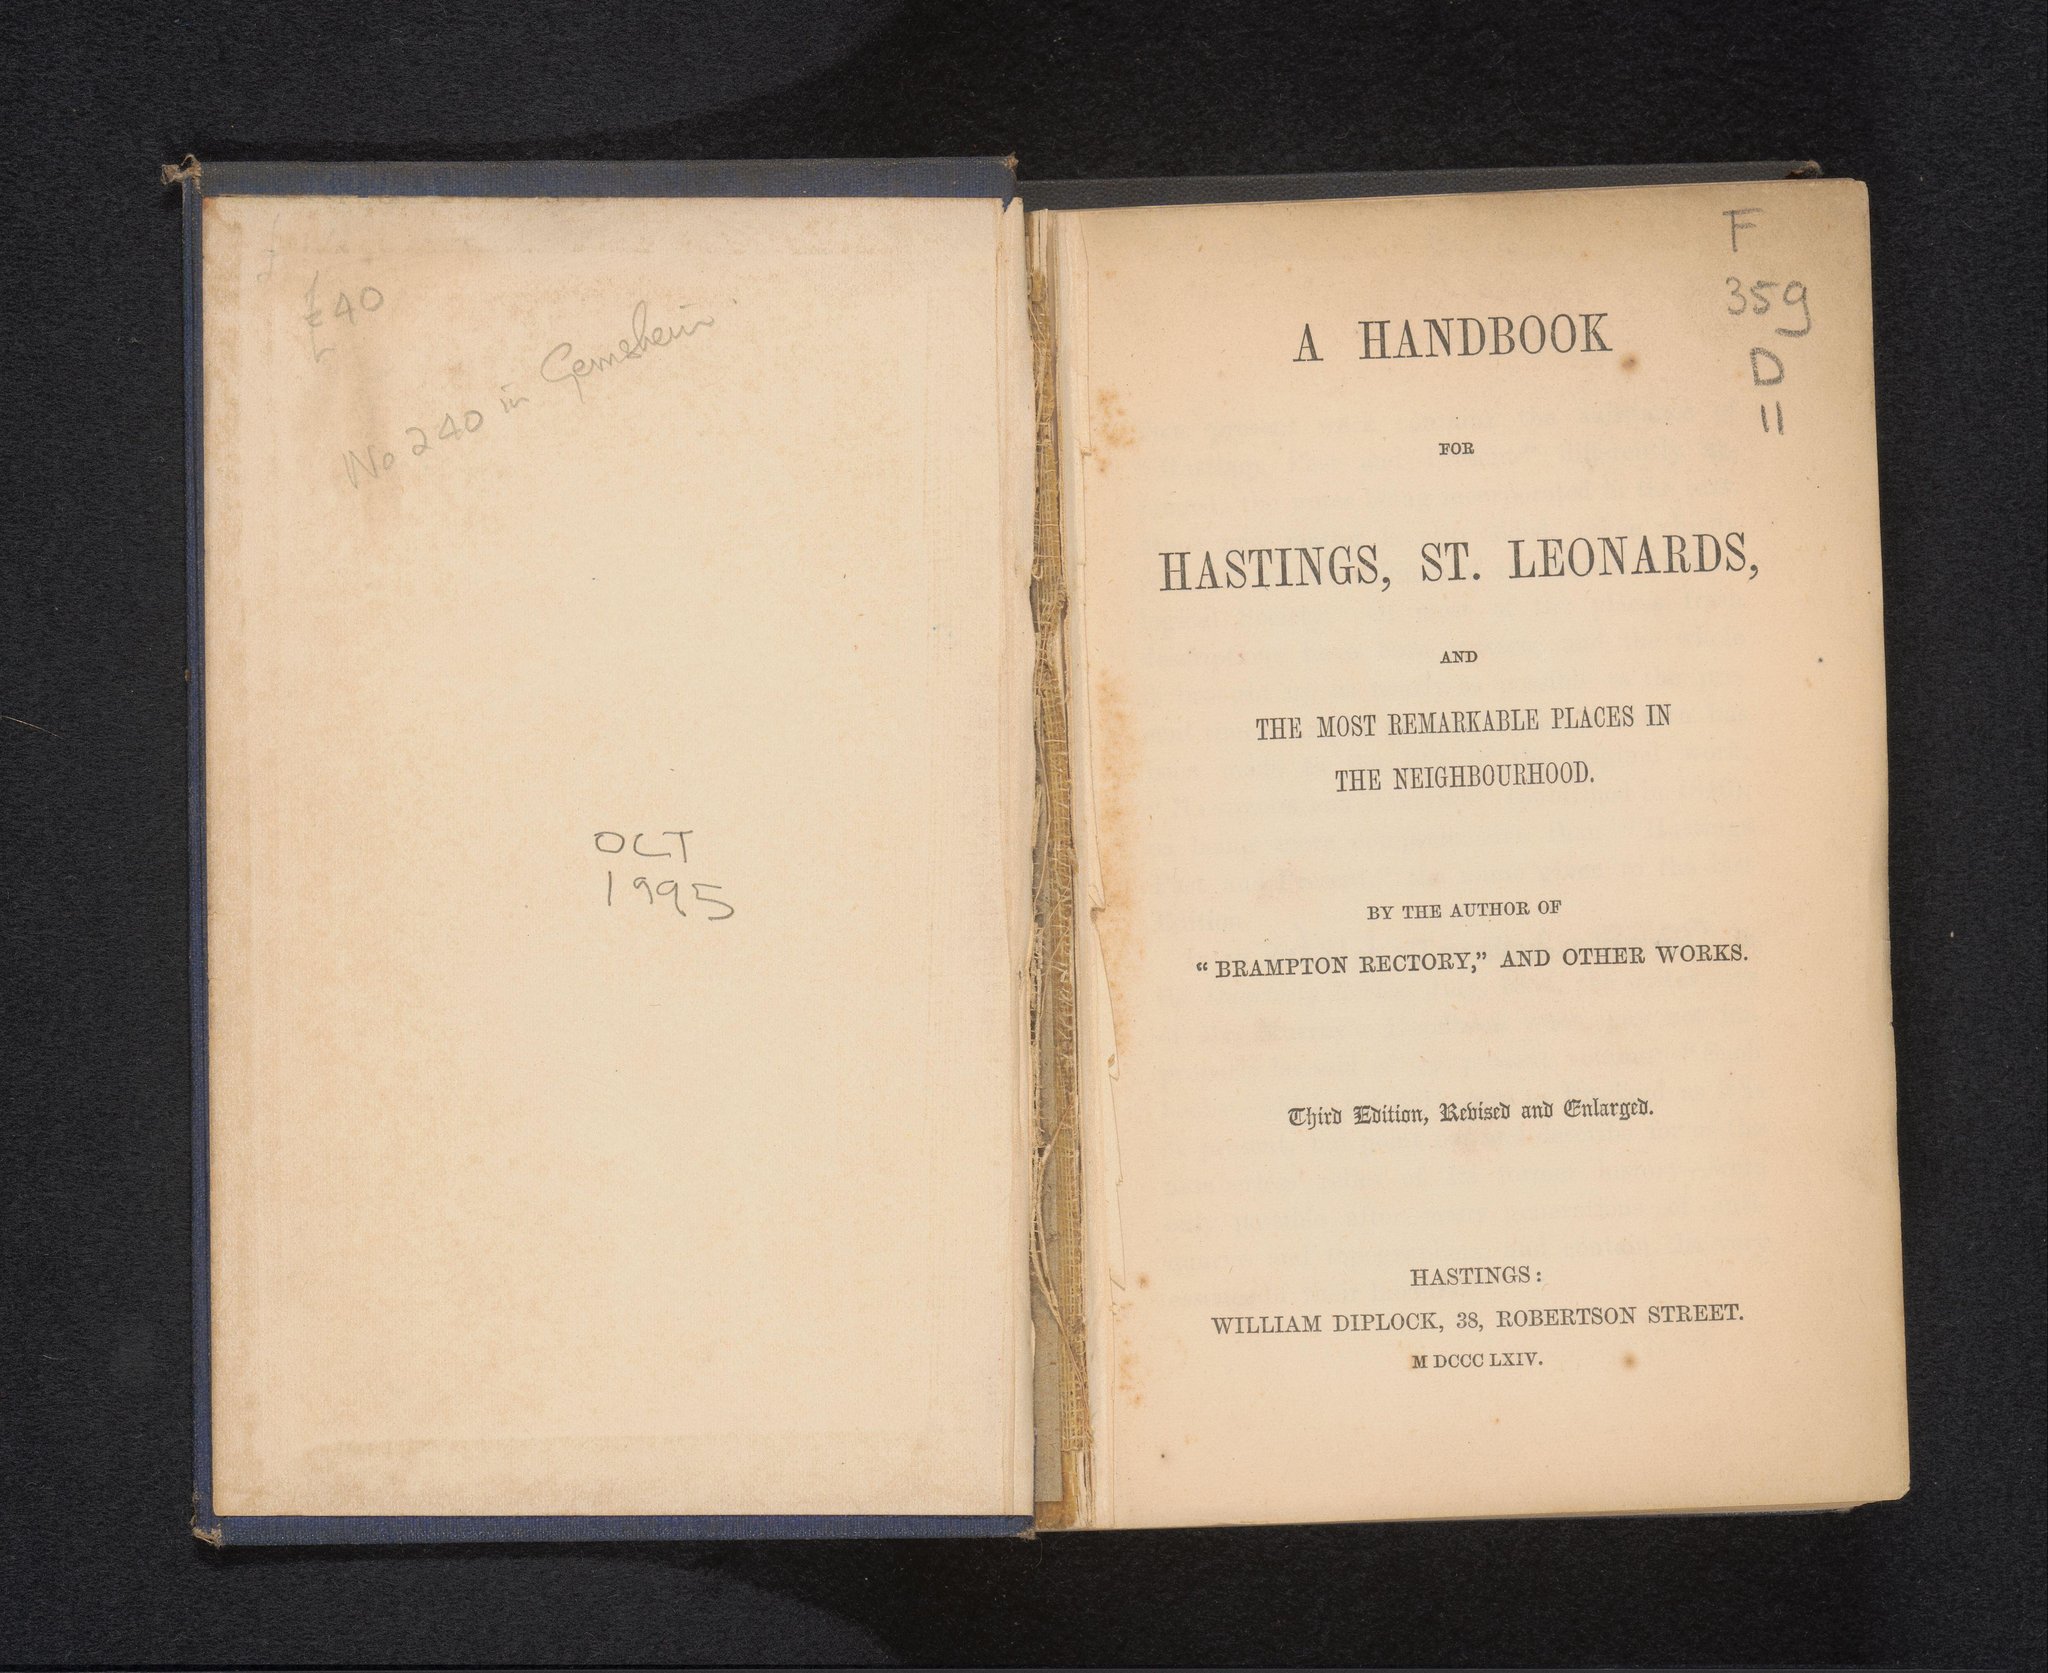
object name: book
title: A handbook for Hastings, St. Leonards, and the most remarkable places in the neighbourhood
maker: william diplock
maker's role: publisher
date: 1864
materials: linen, paper, photographic support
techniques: albumen print, printing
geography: hastings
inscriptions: annotation: ‘£40/ No 240 in Gemshein’, date: ‘Oct 1995’